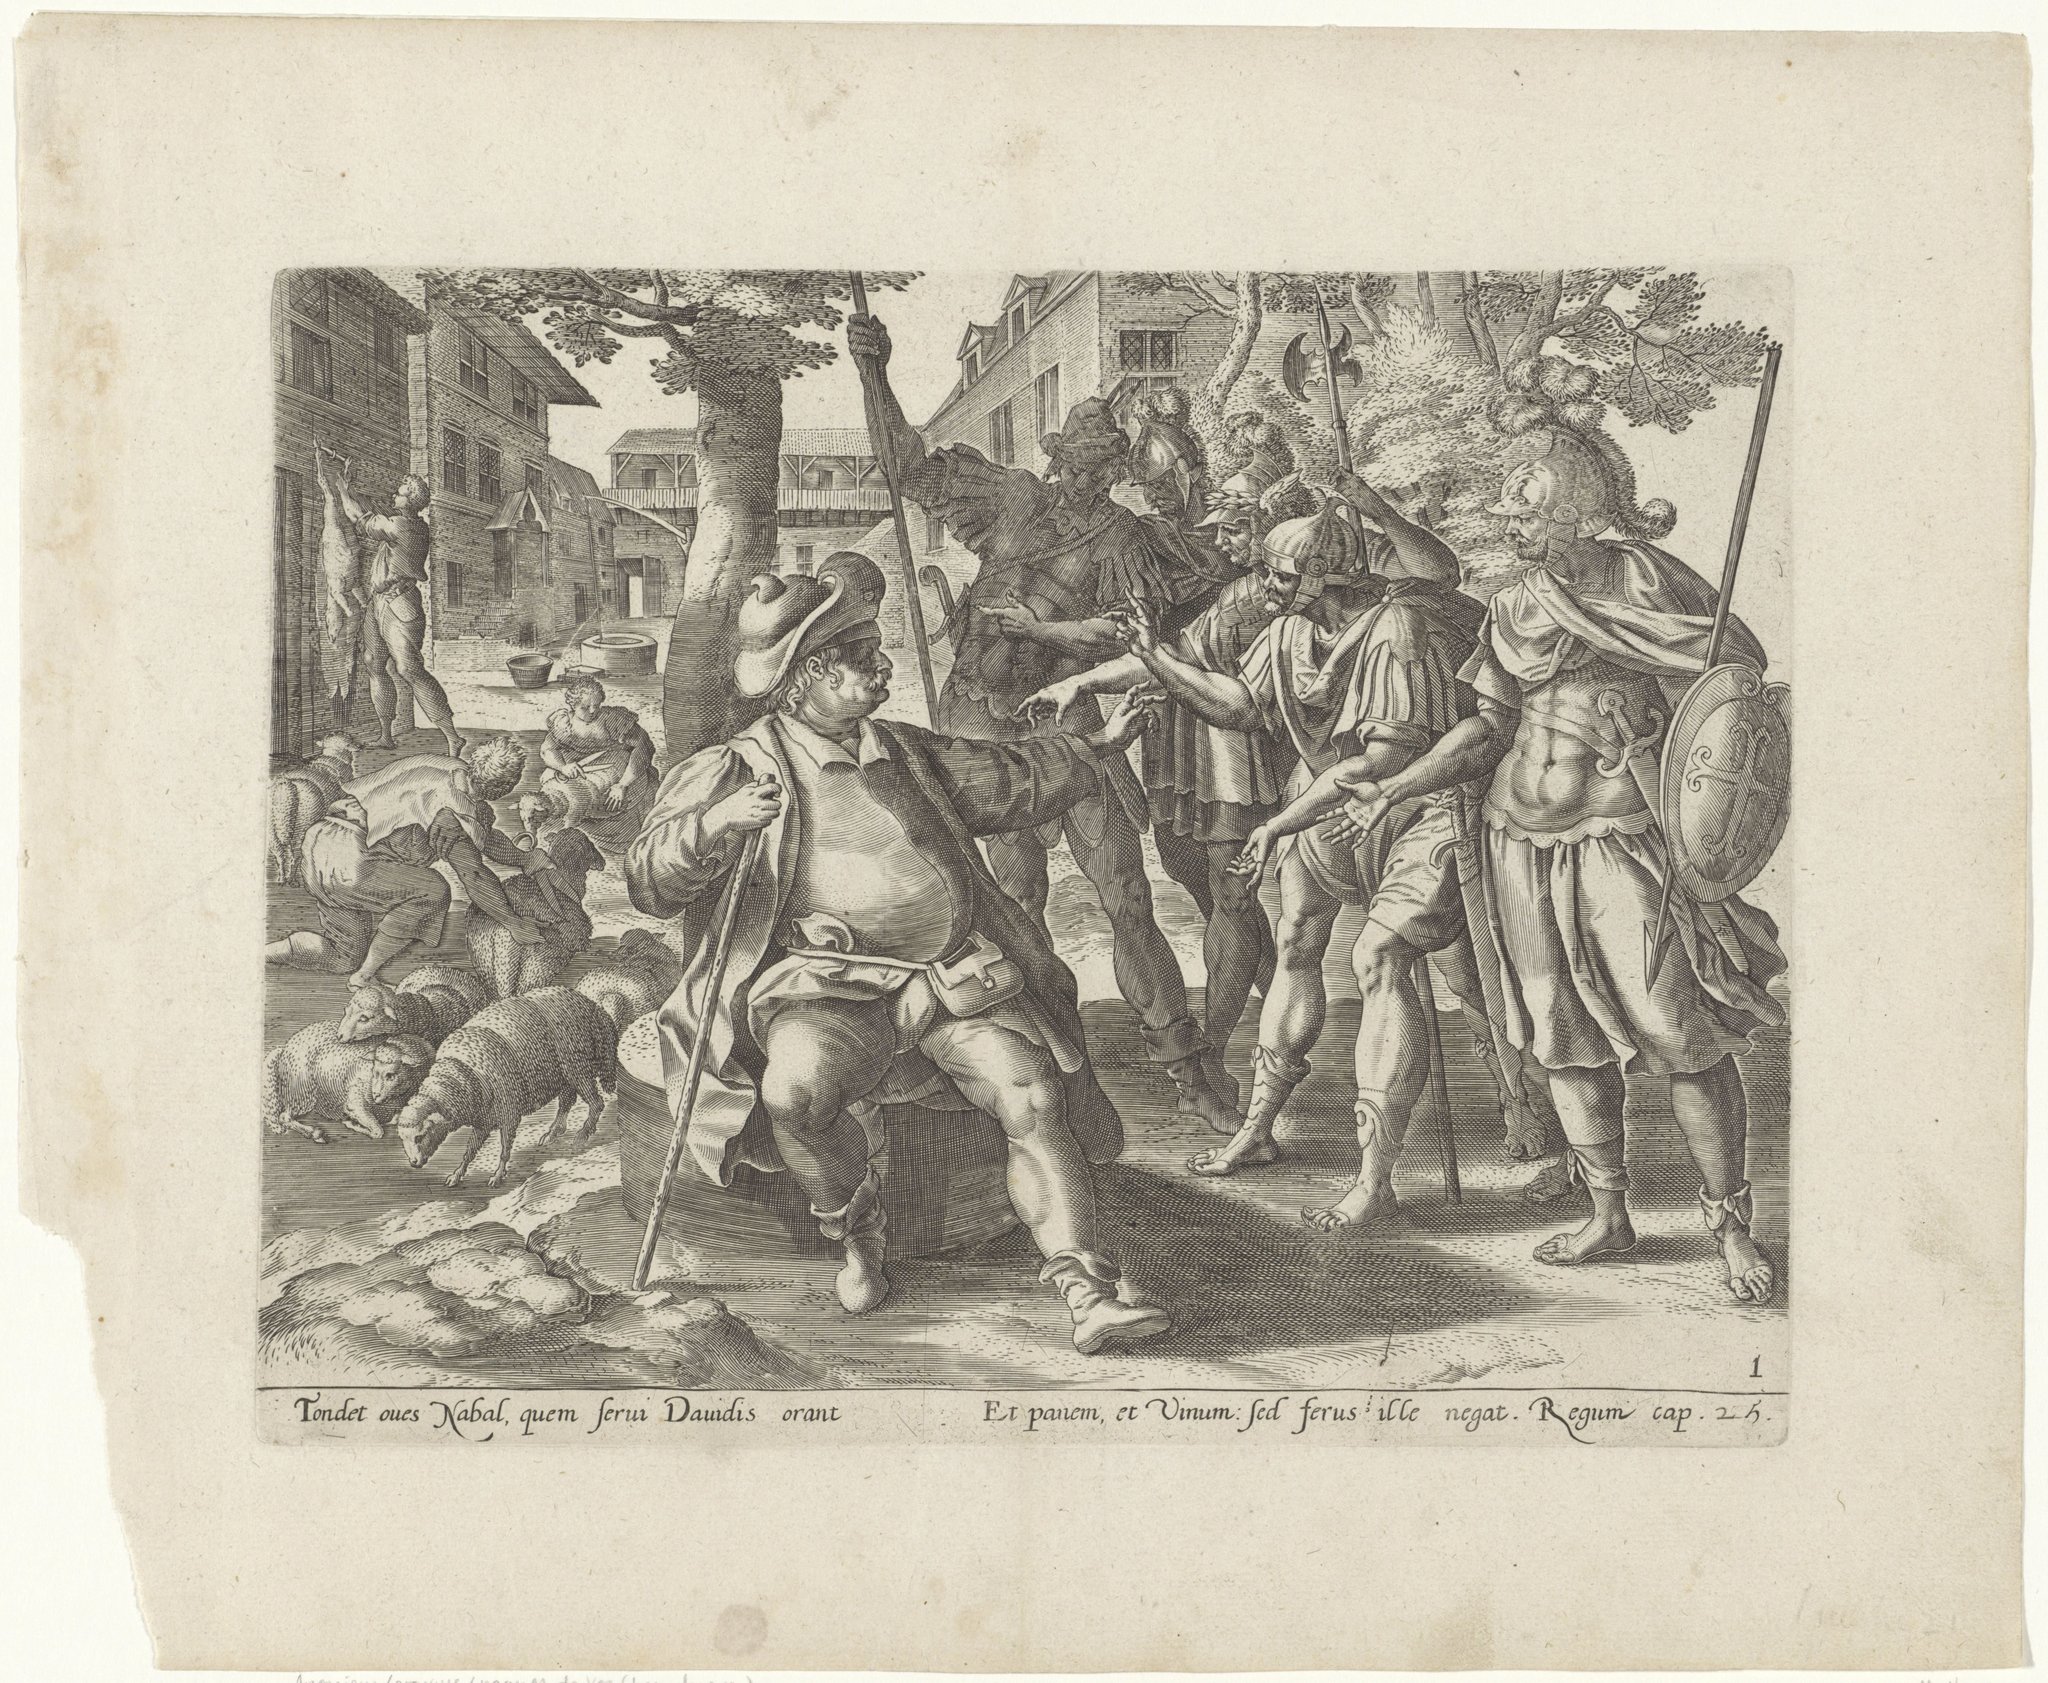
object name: print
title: Geschiedenis van David en Abigaïl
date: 1585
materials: paper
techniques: engraving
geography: antwerp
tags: ten servants sent by david come to nabal to ask for food; nabal and his men may be shown shearing sheep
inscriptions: collector's mark: Lugt 2228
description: Prent gebruikt in: Thesaurus sacrarum historiaru[m] veteris (et novi) testame[n]ti, elega[n]tissimis imaginibus expressu[m] excelle[n]tissimoru[m] in hac arte viroru[m] opera : nu[n]c primu[m] in luce[m] editus. Antwerpen: Gerard de Jode, 1585.